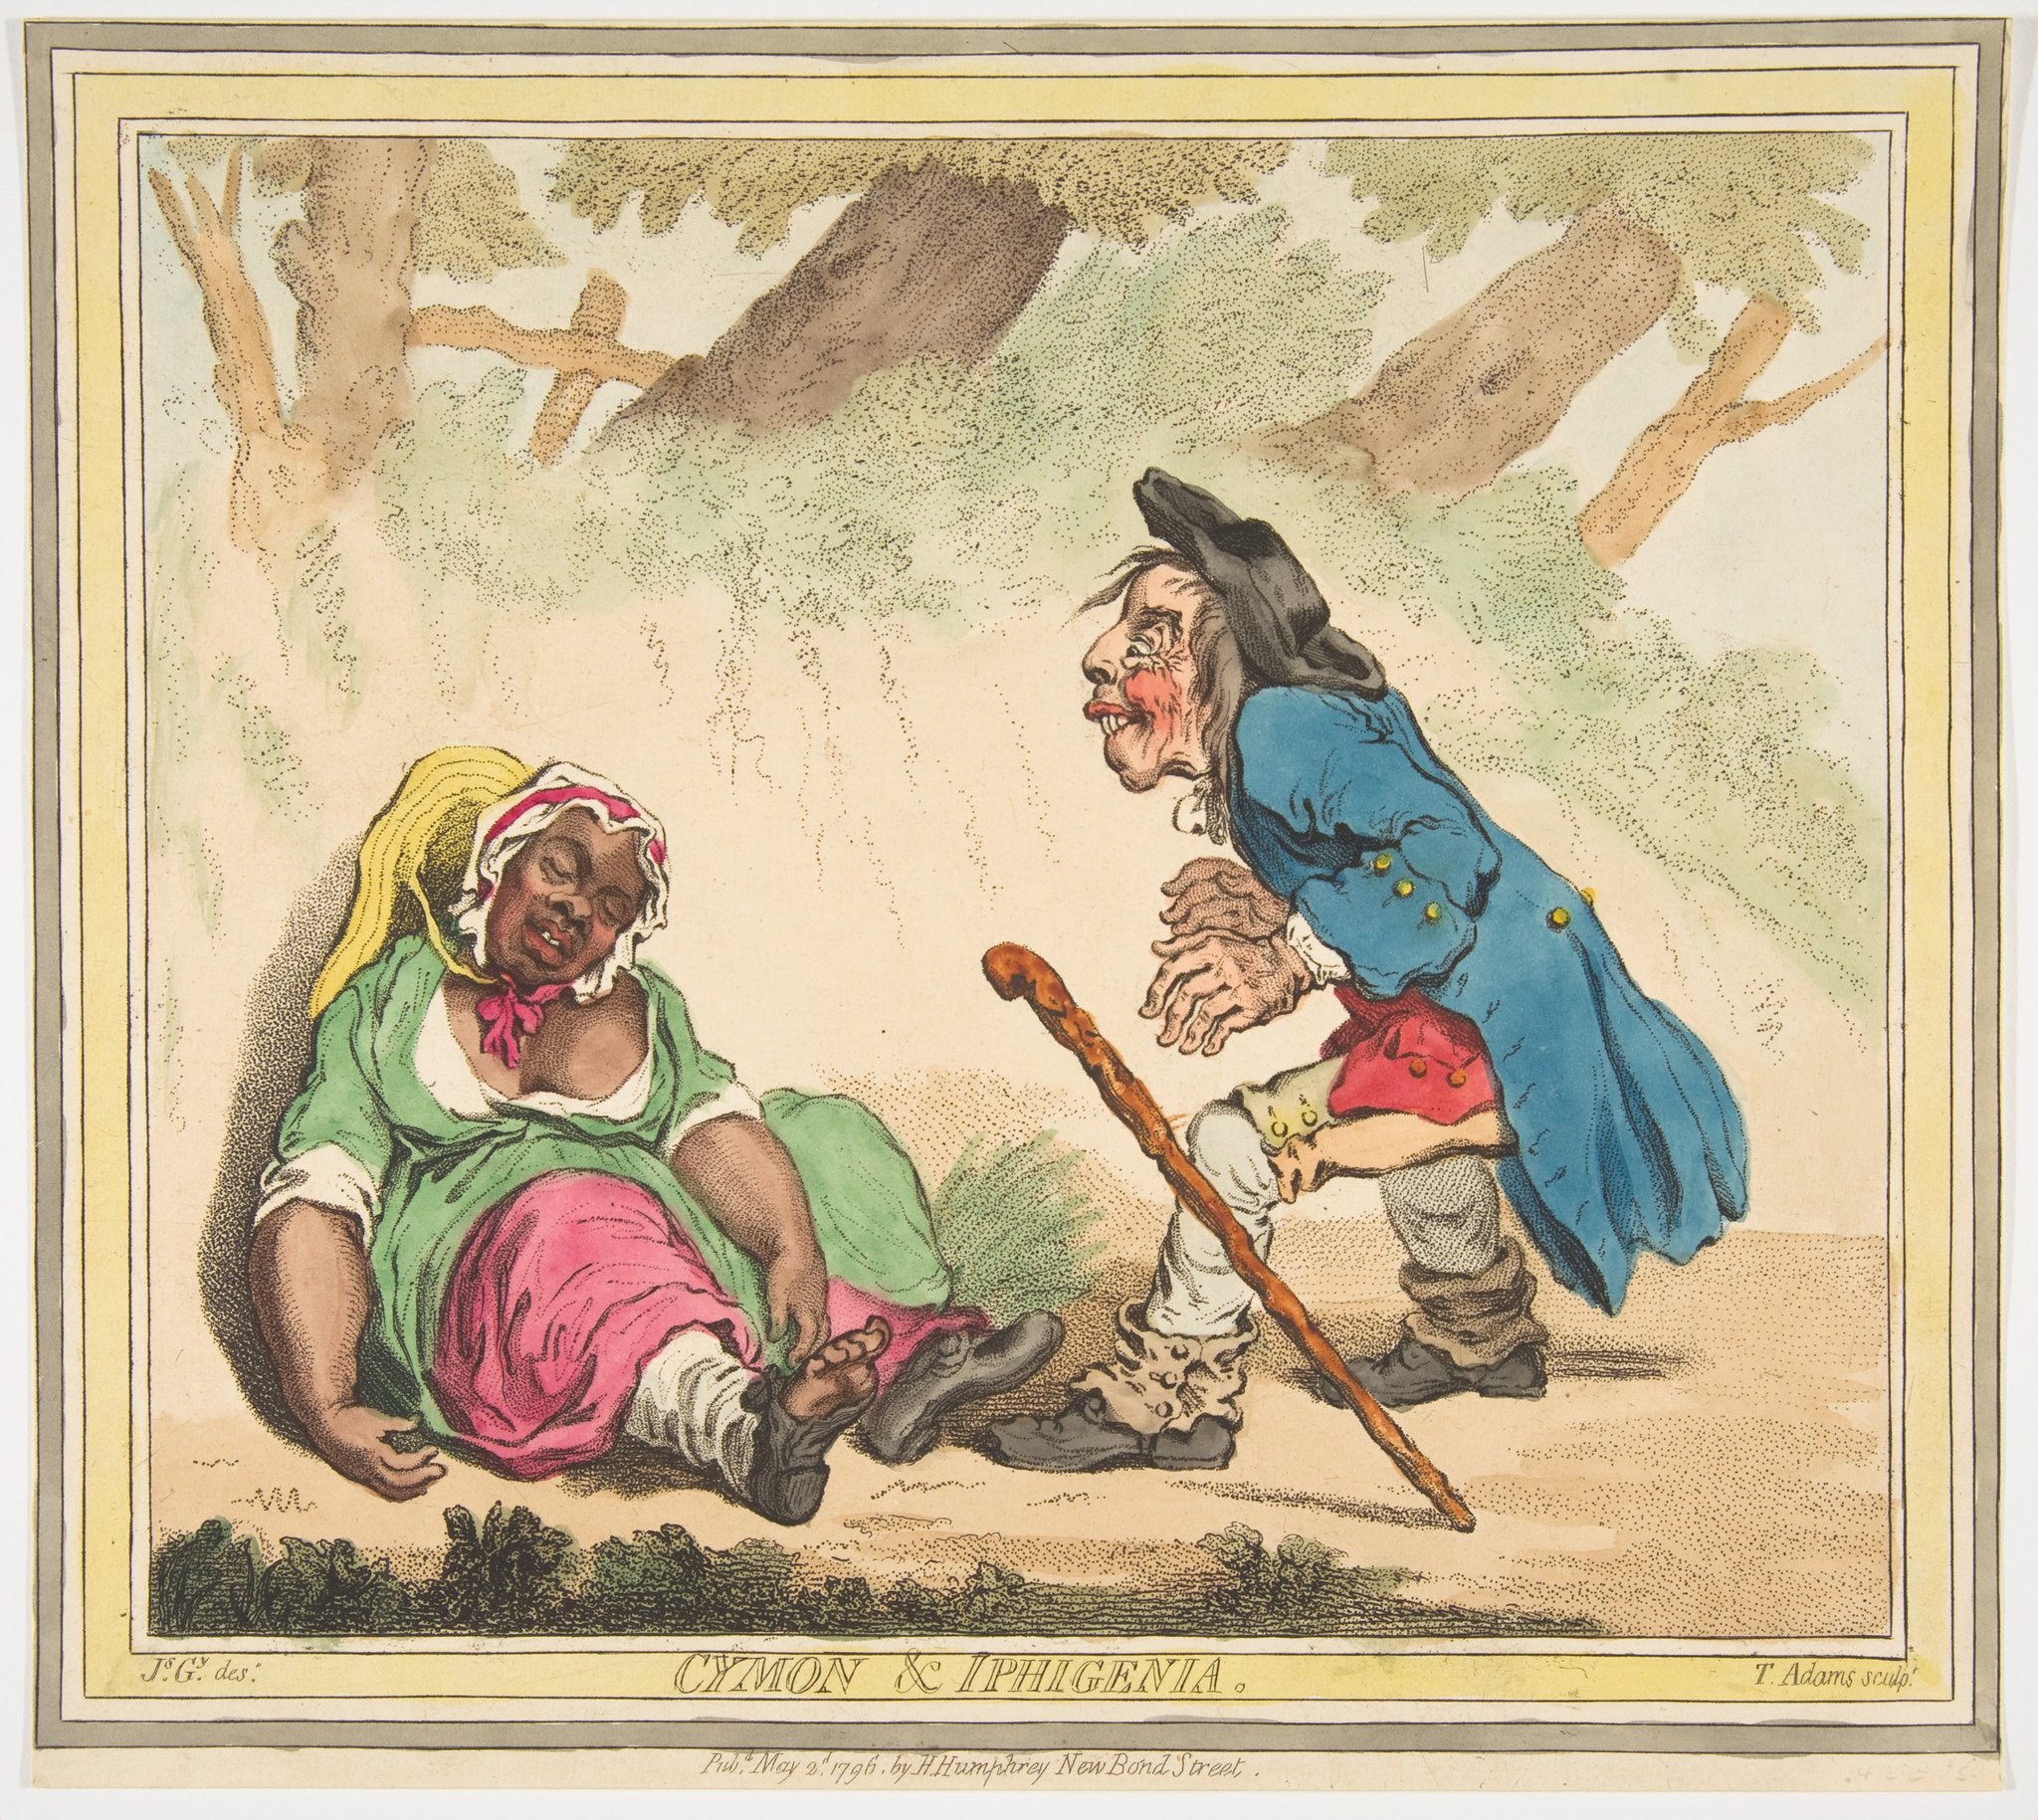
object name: print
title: Cymon and Iphigenia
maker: james gillray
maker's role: artist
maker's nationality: british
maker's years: 1756-1815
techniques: etching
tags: men,women